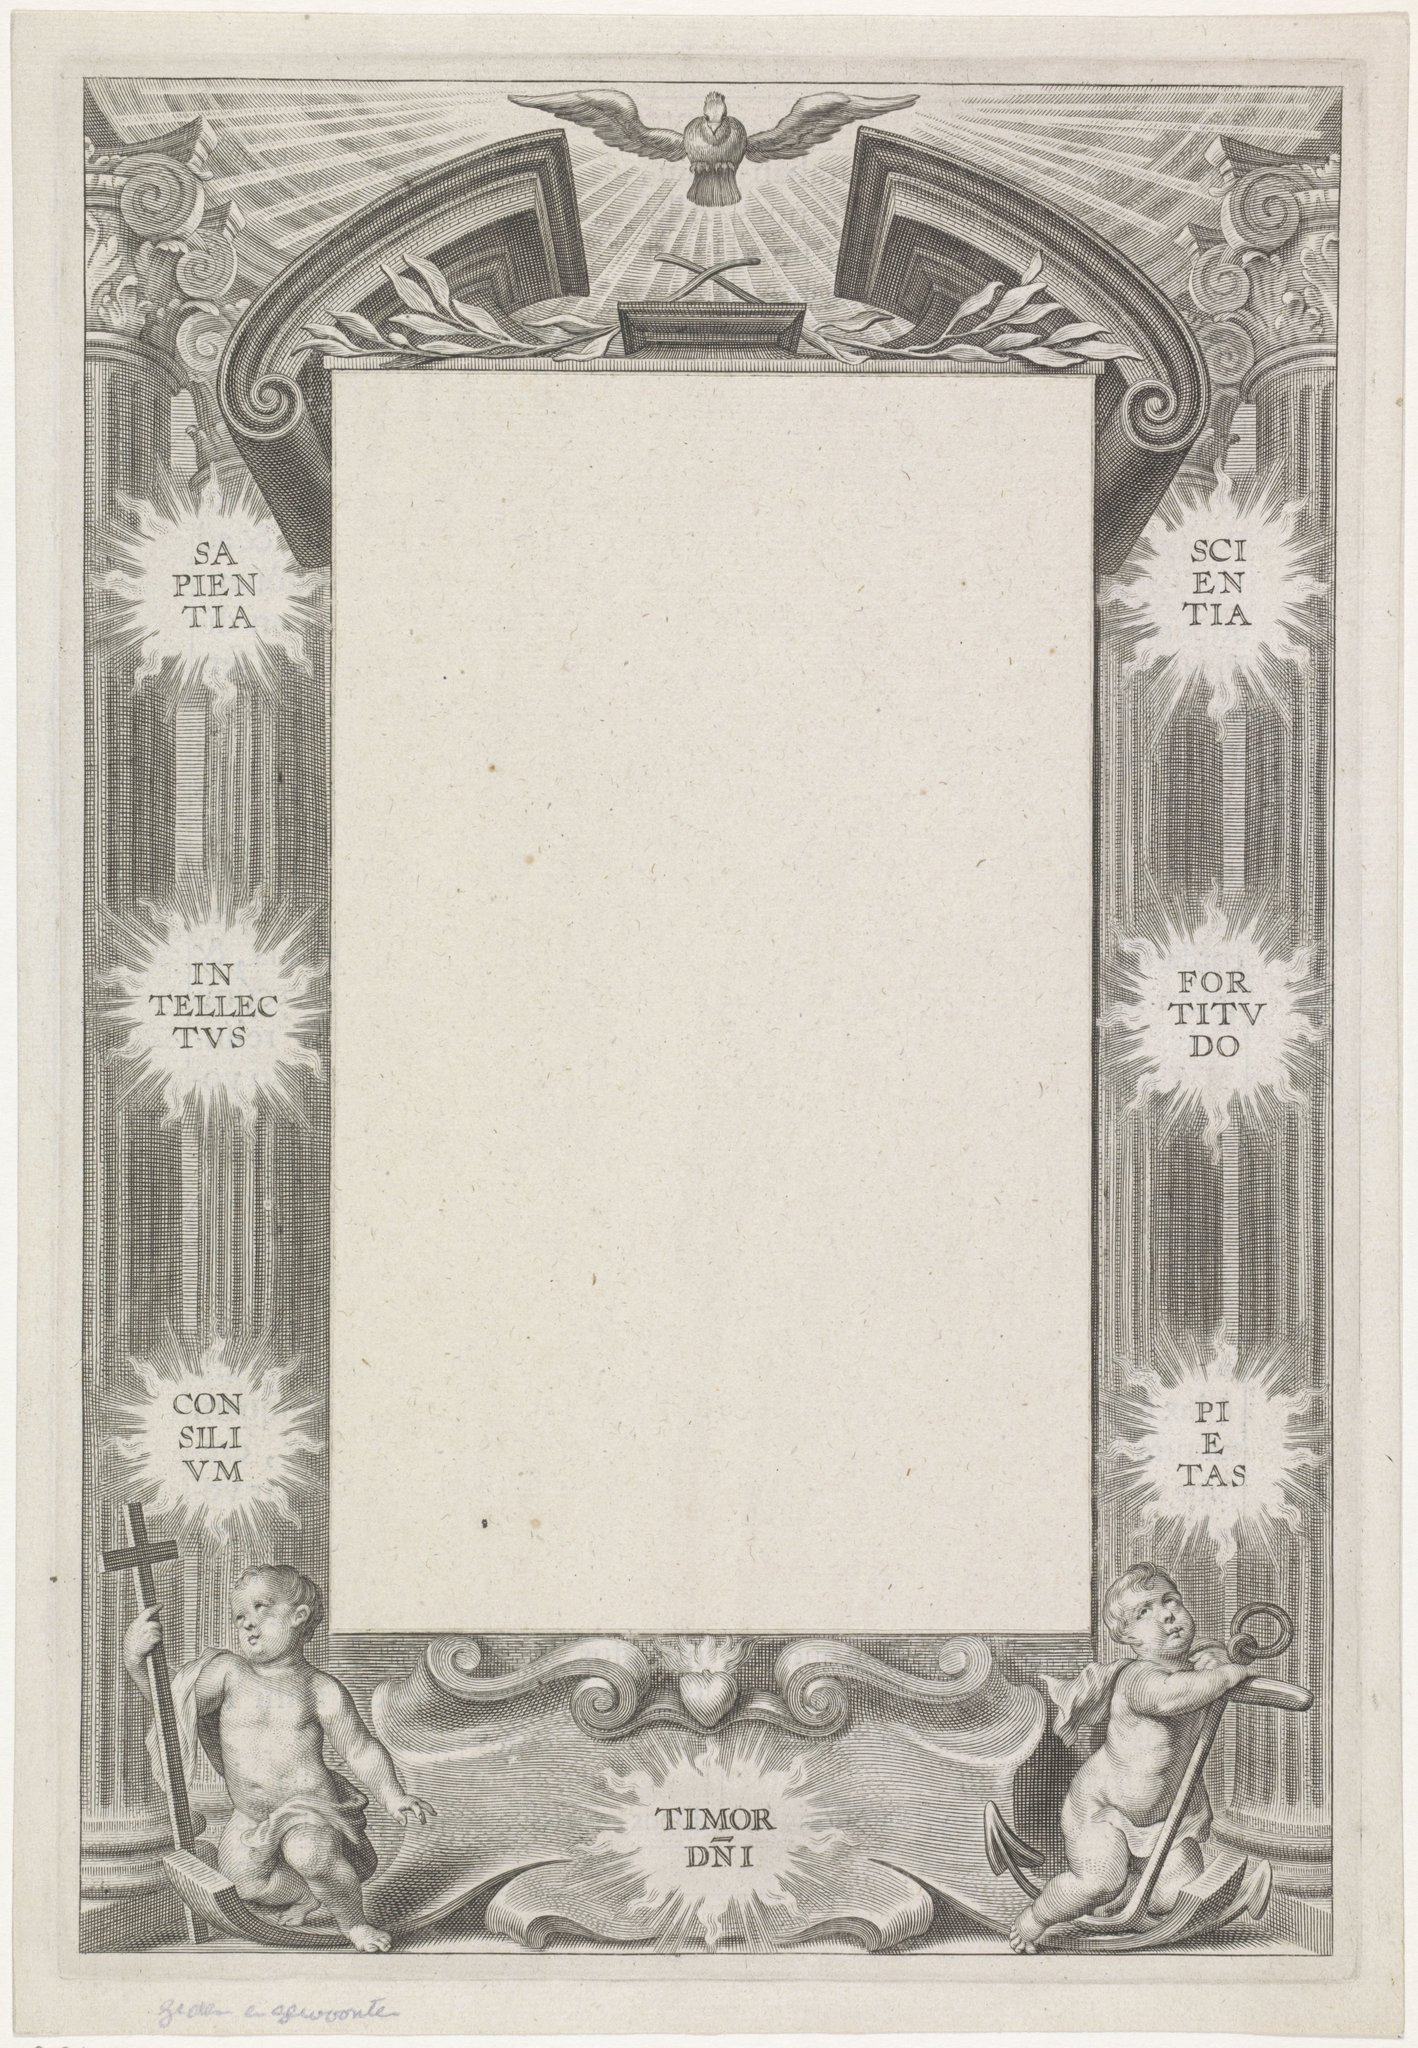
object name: print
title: Omlijsting met de zeven gaven van de Heilige Geest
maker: Anonymous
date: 1650-1750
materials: paper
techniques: engraving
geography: southern netherlands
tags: the seven gifts of the holy ghost represented as seven flames, holy ghost represented otherwise, e.g. ray(s) of light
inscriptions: collector's mark: Lugt 2228, collector's mark: Lugt 240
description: Een omlijsting met een tempel met daarin de zeven gaven van de Heilige Geest. Midden boven de duif van de Heilige Geest. Links, rechts en onder de zeven gaven van de Heilige Geest in vlammen. Onderaan twee putti, de een met kruis van het geloof en de ander met het anker van de hoop.